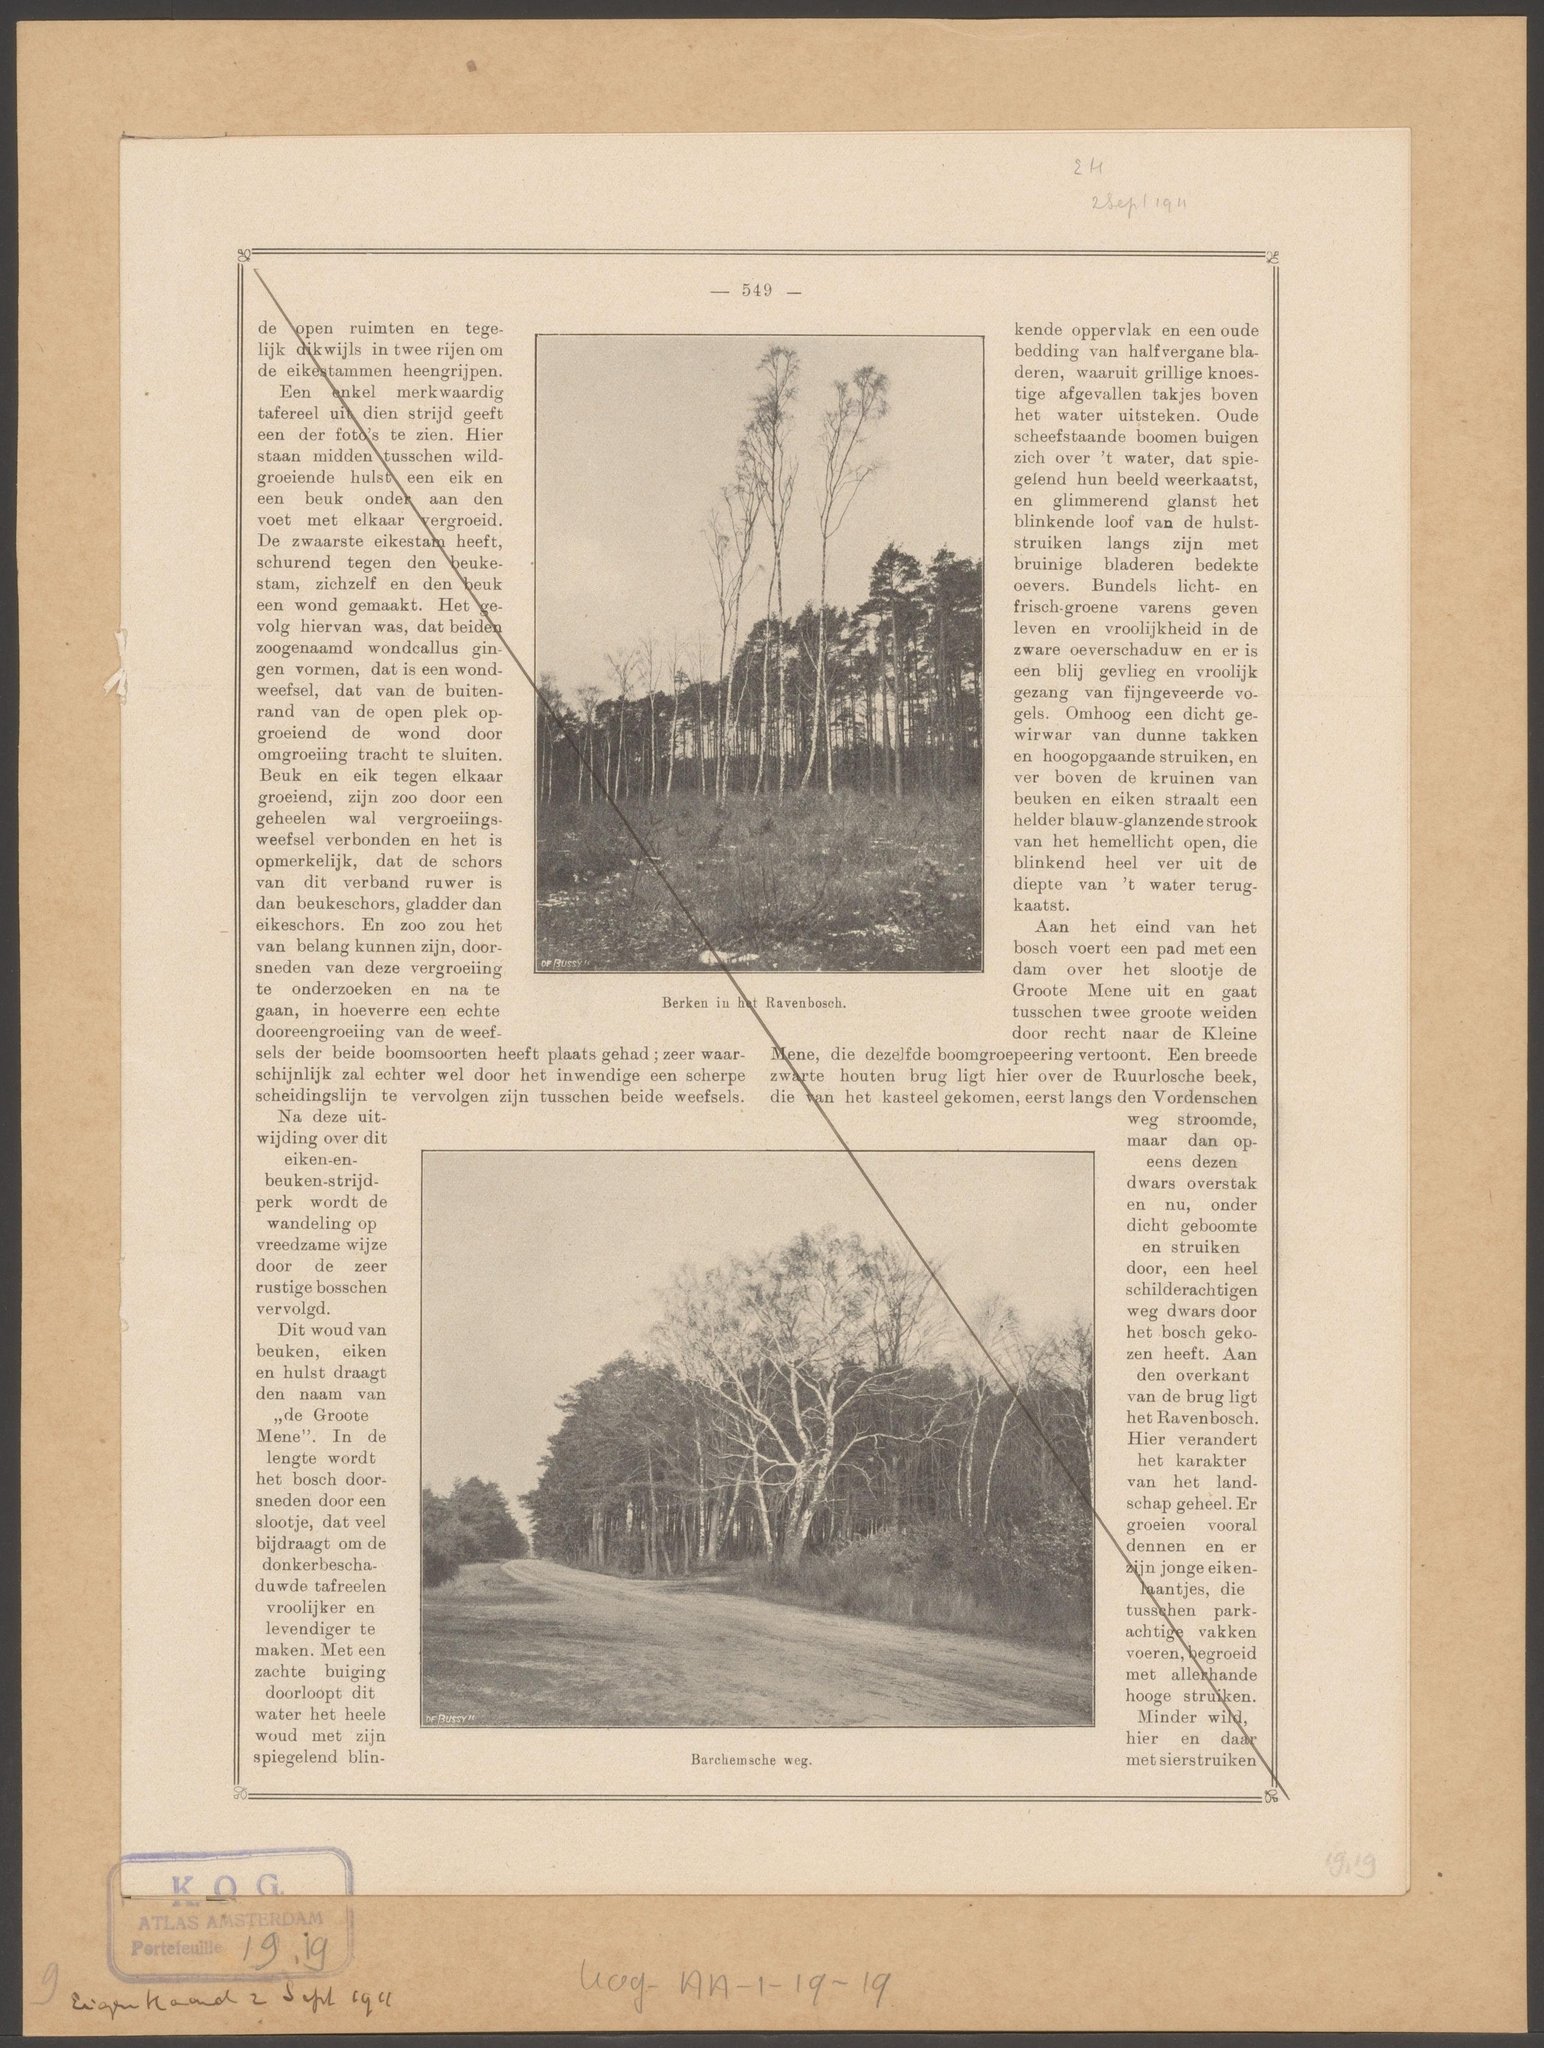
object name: text sheet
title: Biografie van Gijsbert van Tienhoven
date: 1911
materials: paper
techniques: letterpress printing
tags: gijsbert van tienhoven, historical persons, politician, e.g. party leader, amsterdam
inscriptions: collector's mark: ‘19,19’ Lugt 1641b, name: ‘J.C. Matthes’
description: Onderwerpsrubriek binnen de Atlas Amsterdam: Herinneringen aan regeringsleden en hunne huisgezinnen [na 1800]. Drie bladzijden uit het tijdschrift Eigen Haard van 1911.